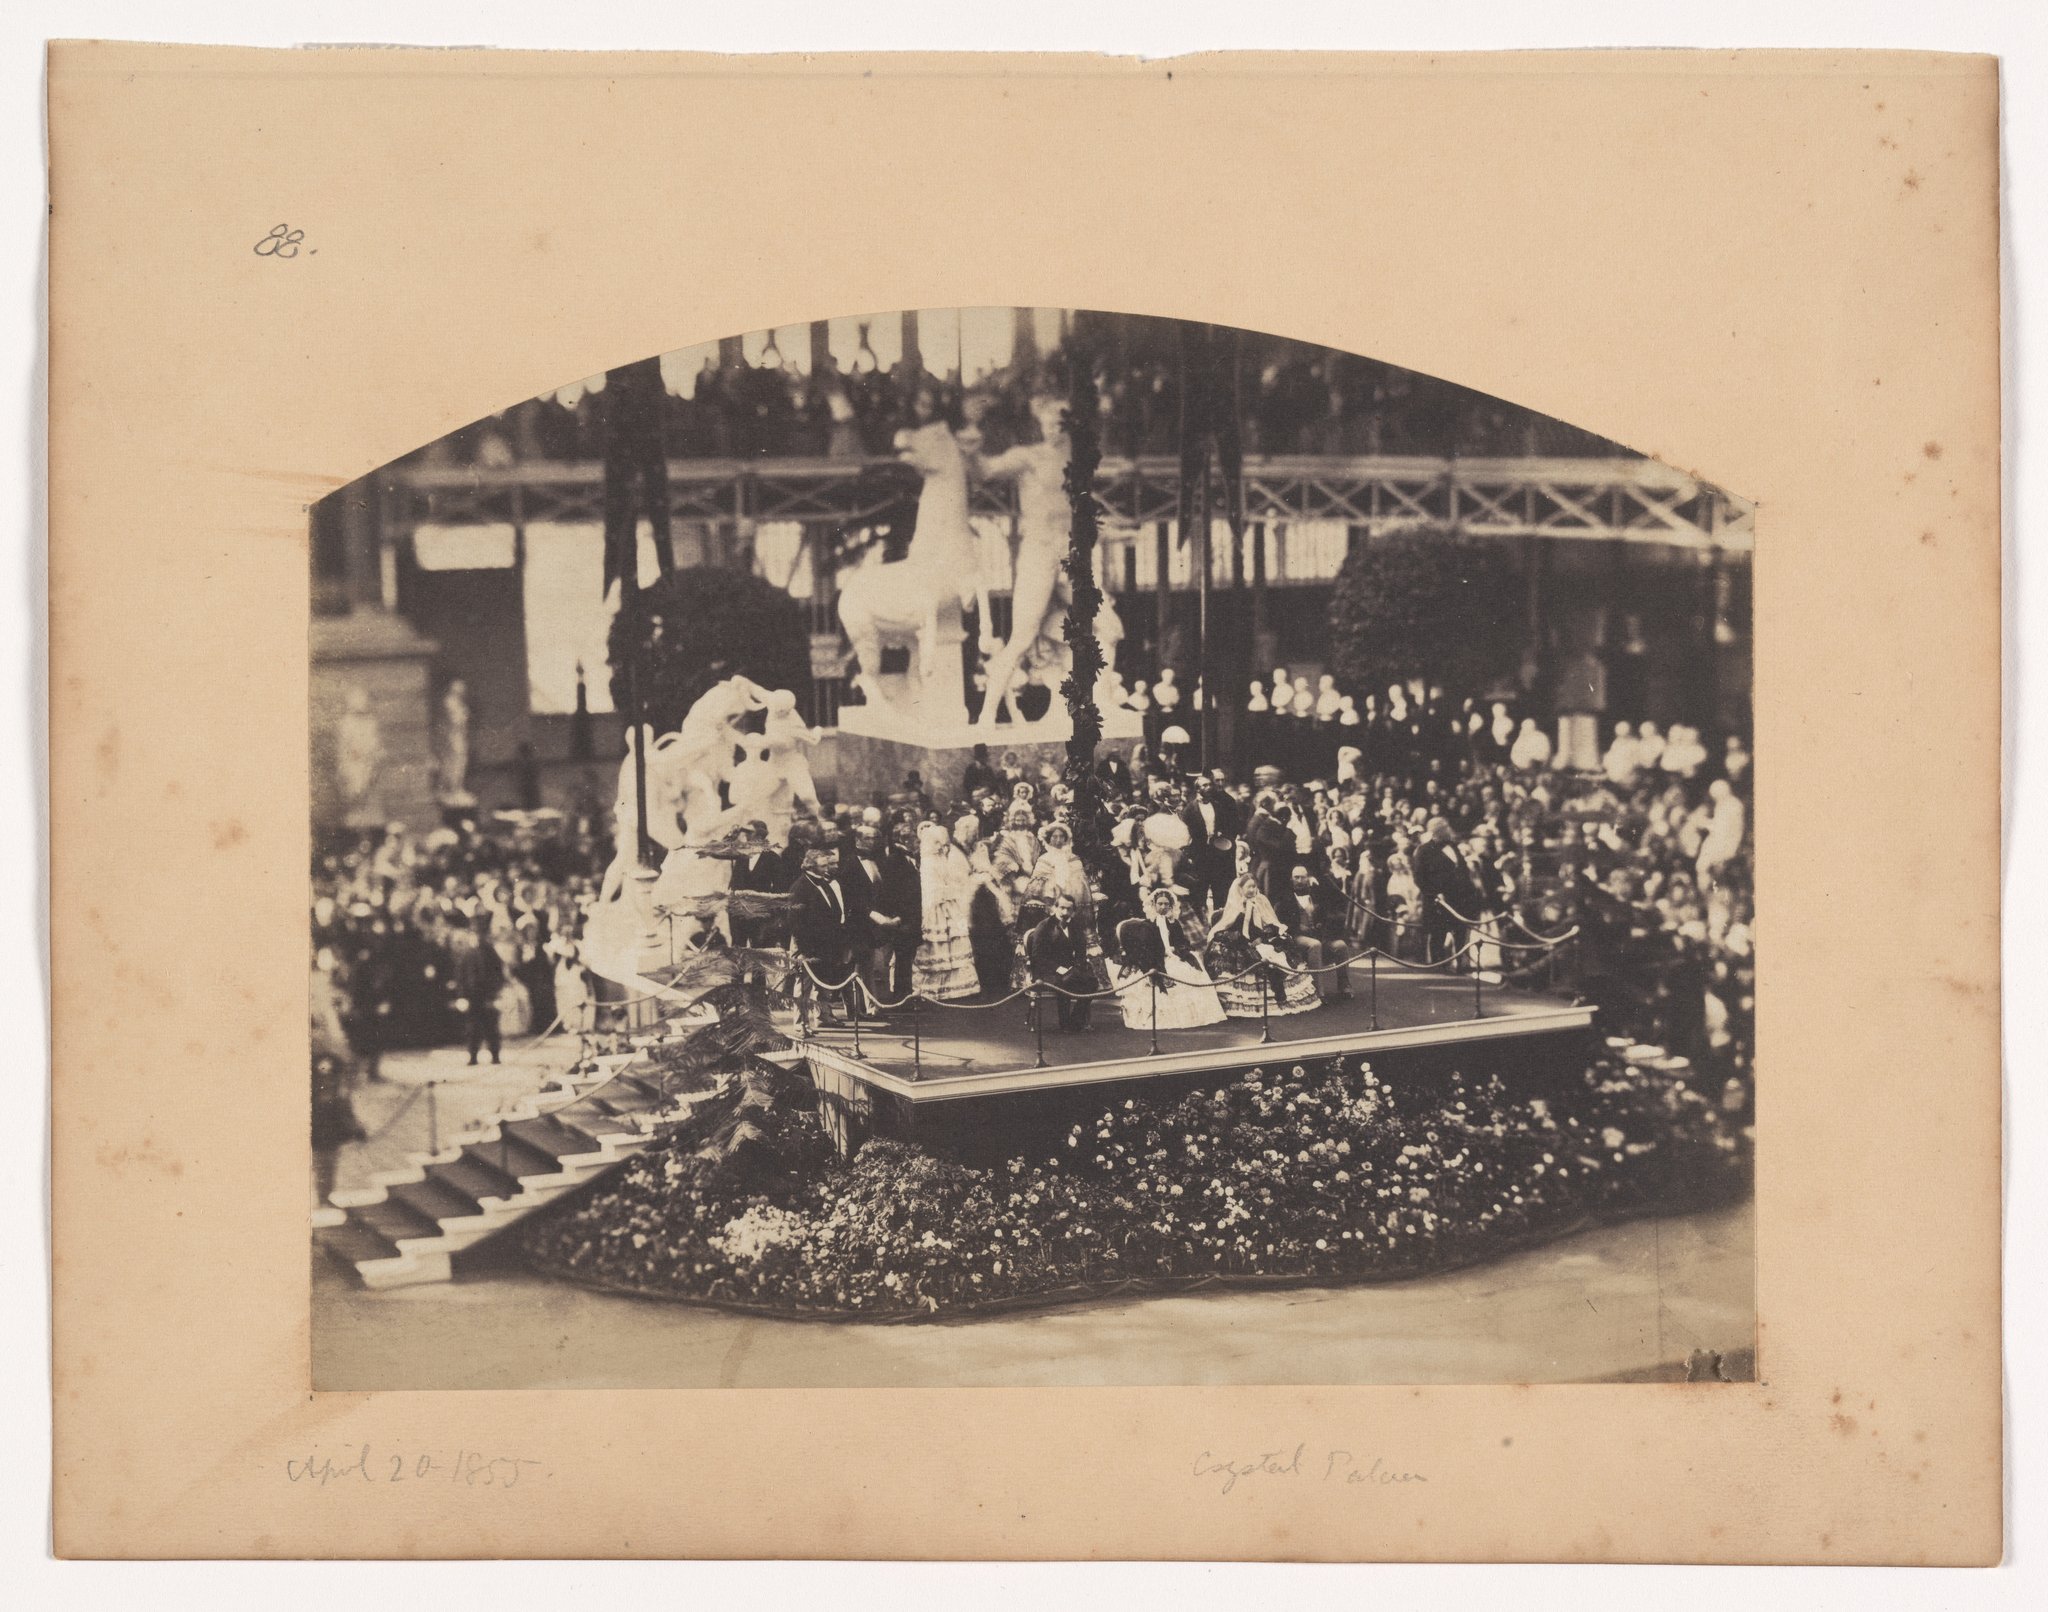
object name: photograph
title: The Visit of the Emperor and Empress to the Crystal Palace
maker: philip henry delamotte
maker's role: artist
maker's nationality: british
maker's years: 1821-1889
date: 1855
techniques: albumen silver print, glass negative